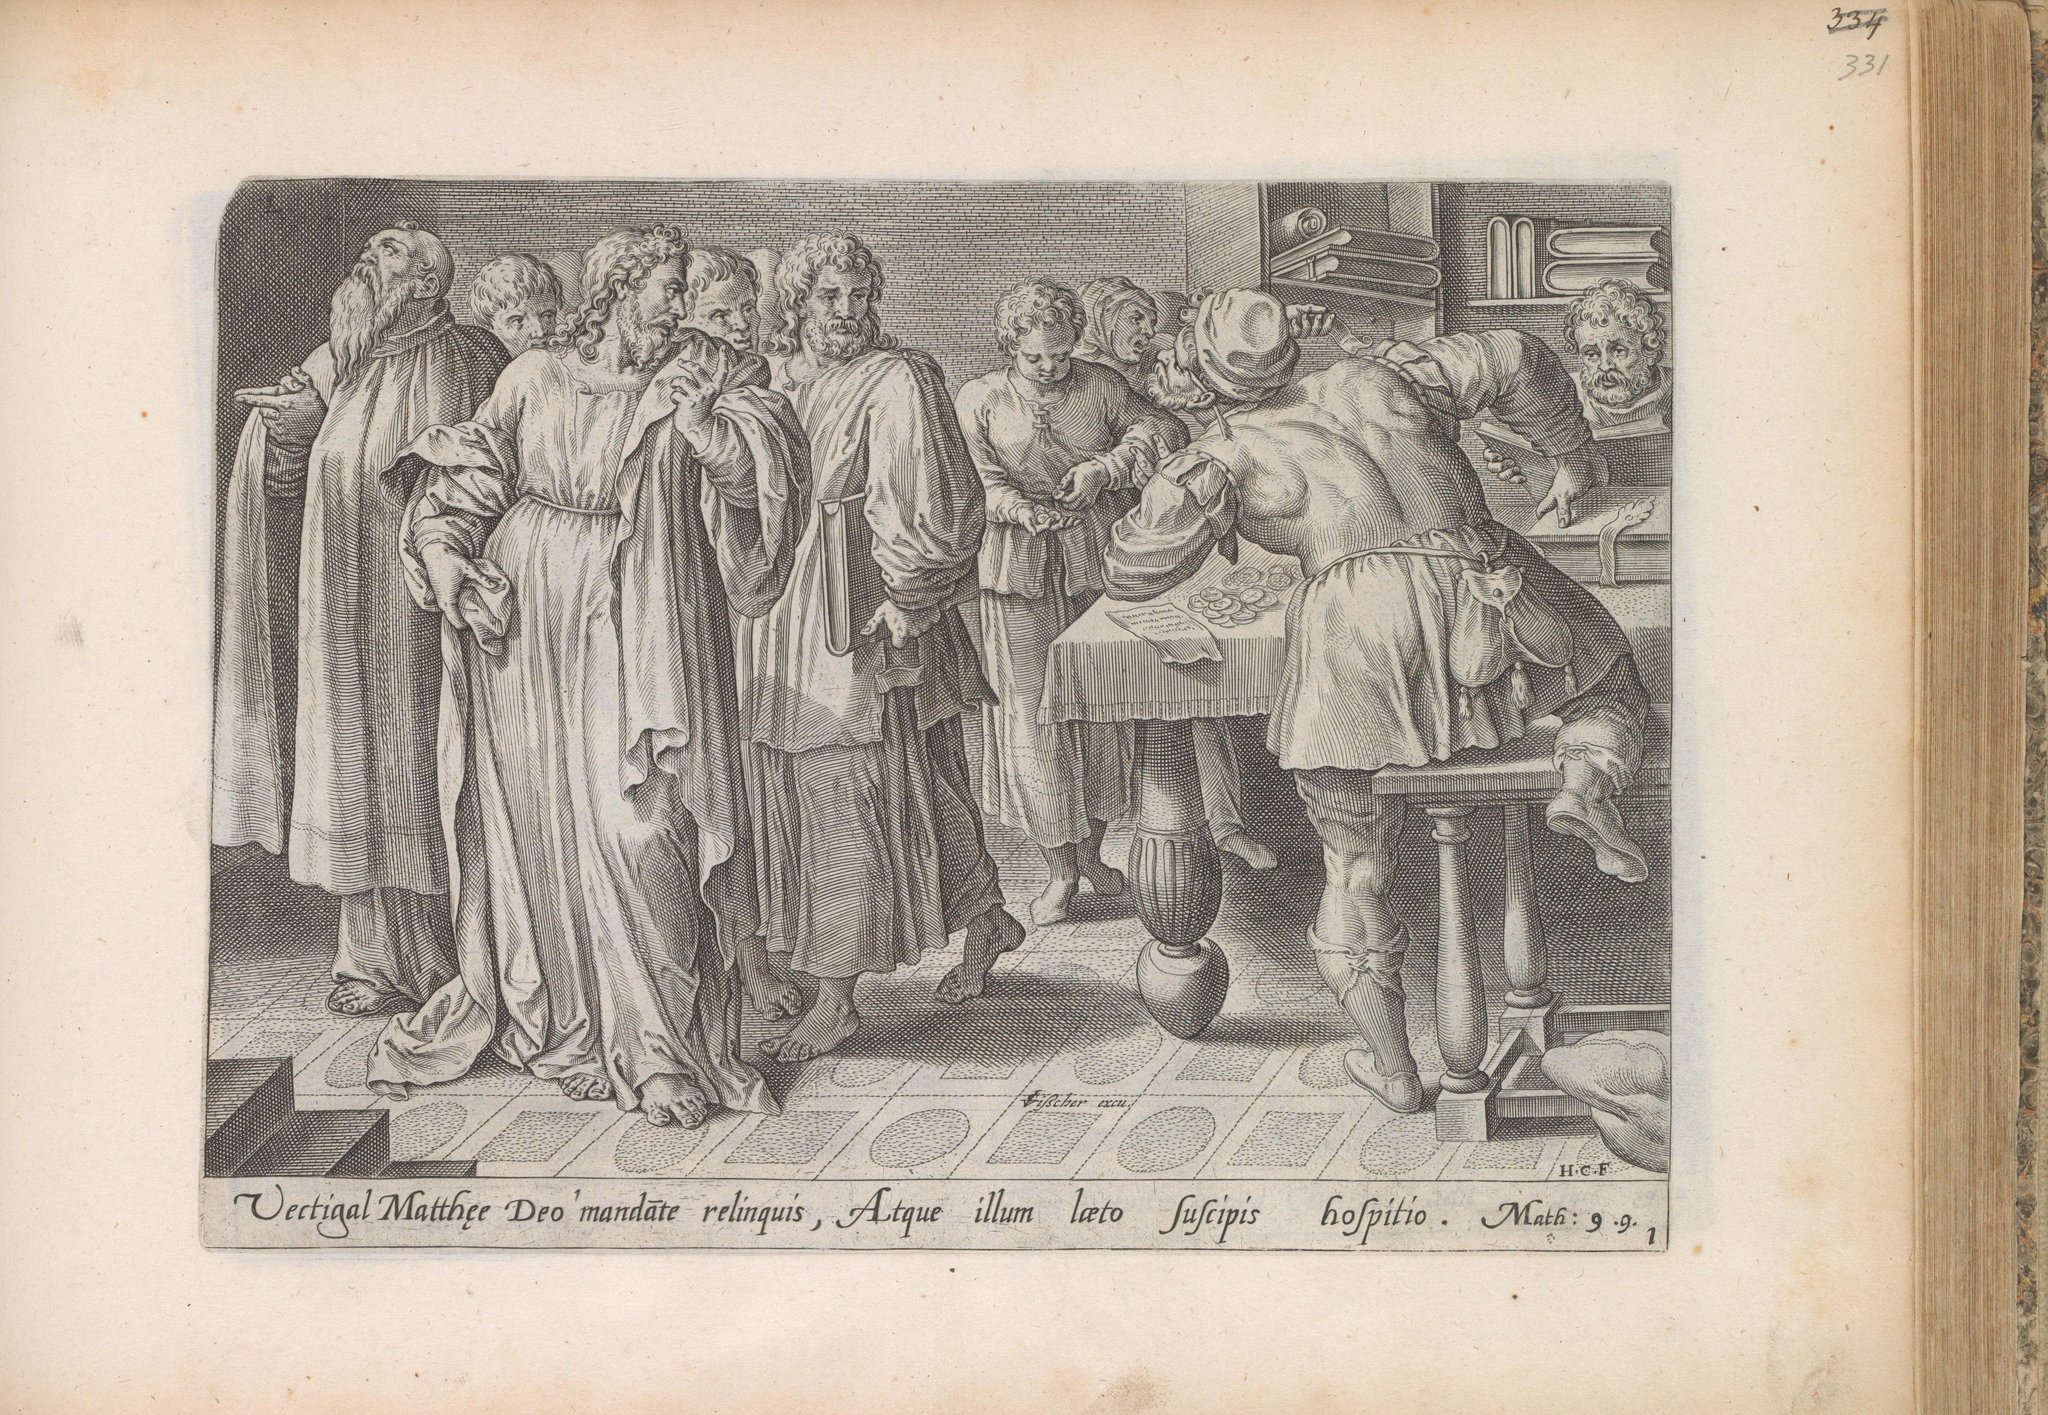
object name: album leaf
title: Roeping van Matteüs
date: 1585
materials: paper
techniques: engraving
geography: amsterdam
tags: calling of matthew (levi), the tax-collector (usually with money lying on the table and people paying taxes) (matthew 9:9; mark 2:14; luke 5:27-28)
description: Christus passeert met zijn leerlingen de tollenaar Matteüs en vraagt hem hem te volgen. Matteüs staat op van zijn bank en verlaat de tafel waar hij belasting int. Onder de voorstelling een verwijzing in het Latijn naar de Bijbeltekst in Mat. 9:9. Deze prent maakt deel uit van een album.